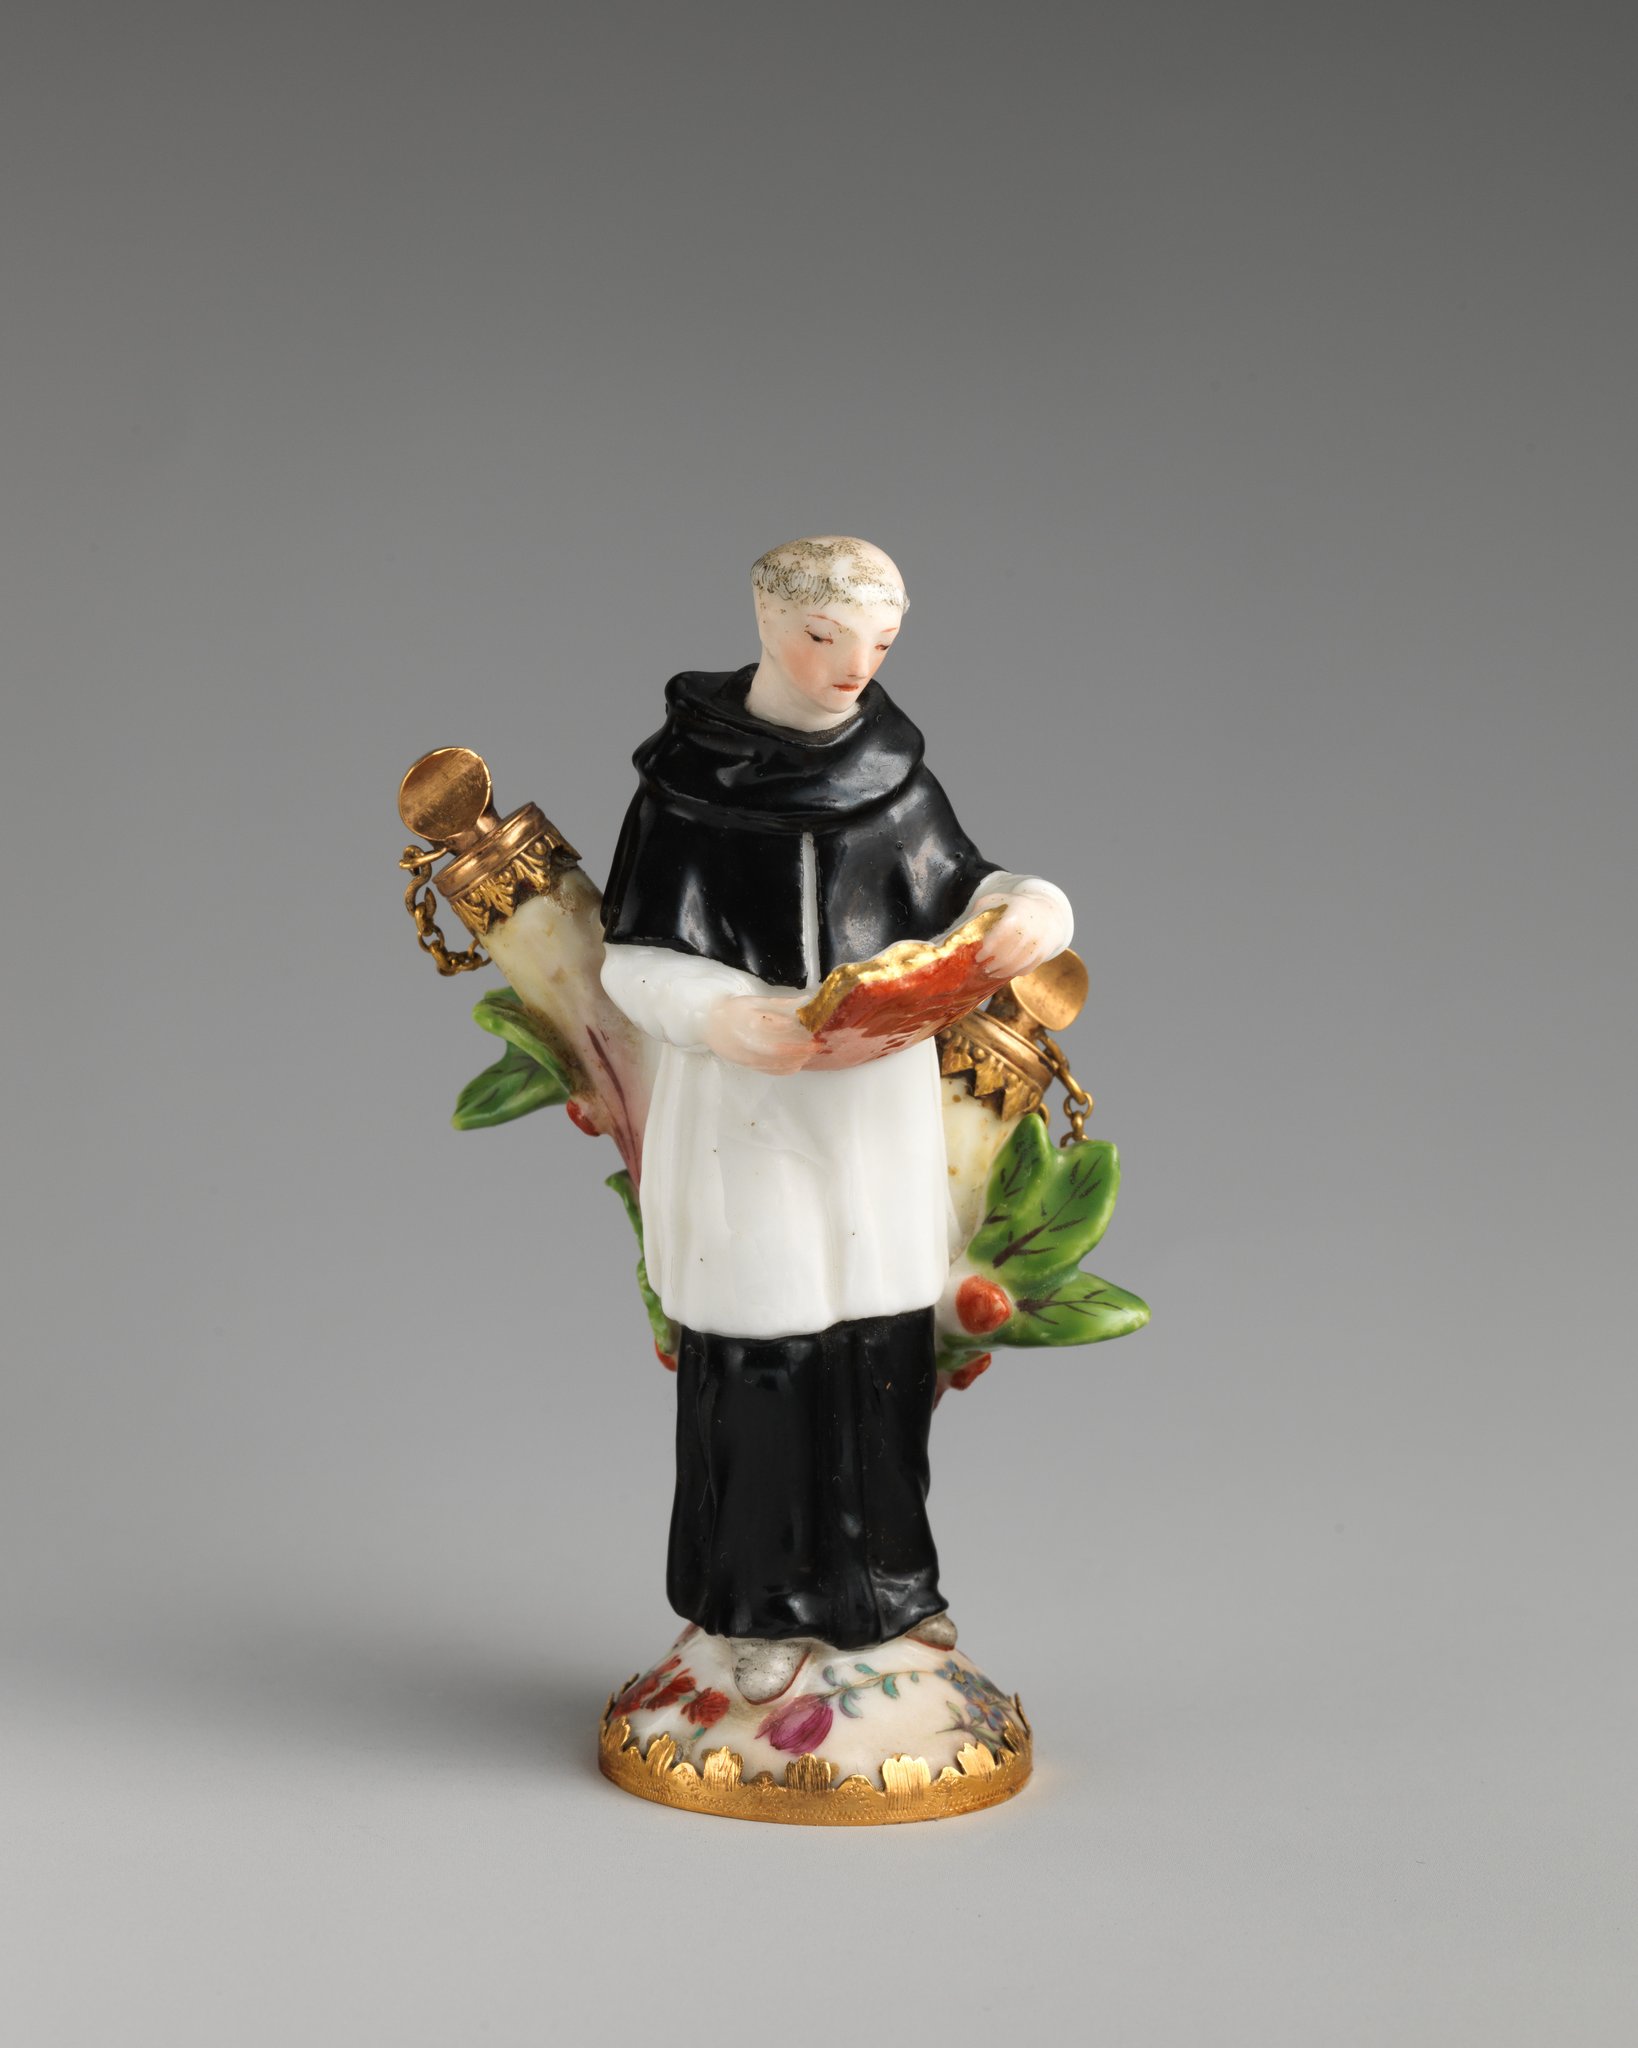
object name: toy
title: Priest with missal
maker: chelsea porcelain manufactory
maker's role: factory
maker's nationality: british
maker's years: 1744-1784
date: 1755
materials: soft paste porcelain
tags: books,men,reading